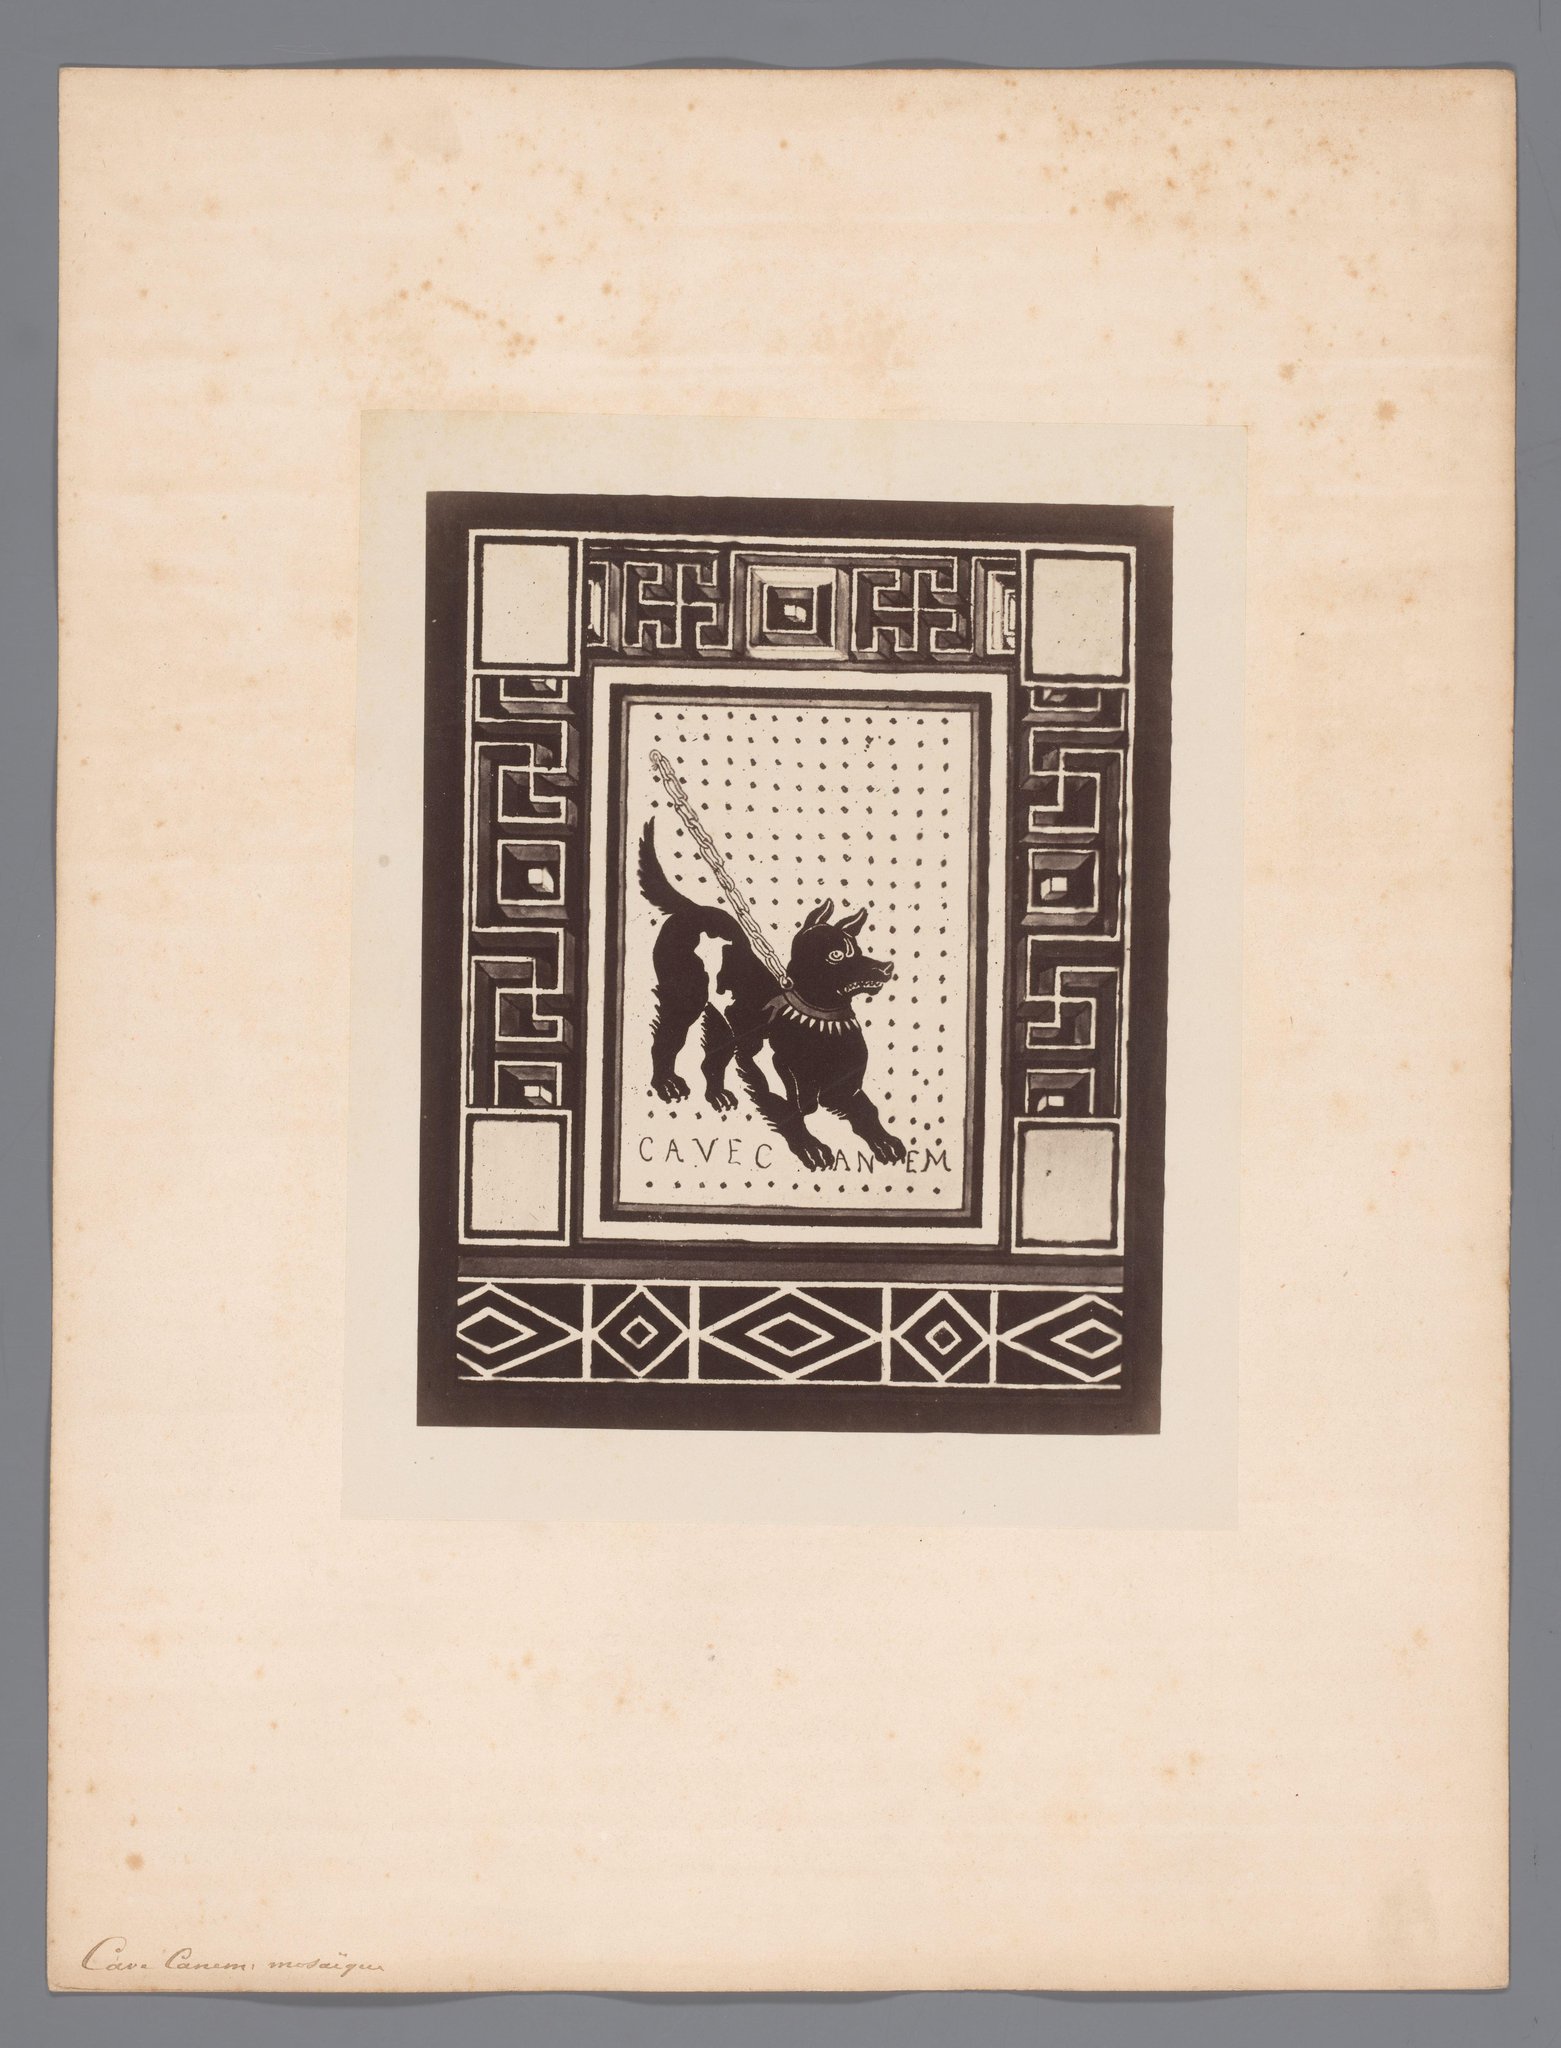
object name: photograph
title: Mozaïekvloer met waakhond in huis te Pompeï, Italië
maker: Anonymous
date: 1851-1900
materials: cardboard, paper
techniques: albumen print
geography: pompeii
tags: floor-covering, watch-dog, dog watching, pompeii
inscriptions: number: ‘11’, number: ‘69.’, inscription: ‘Cave Canem, mozaiek’